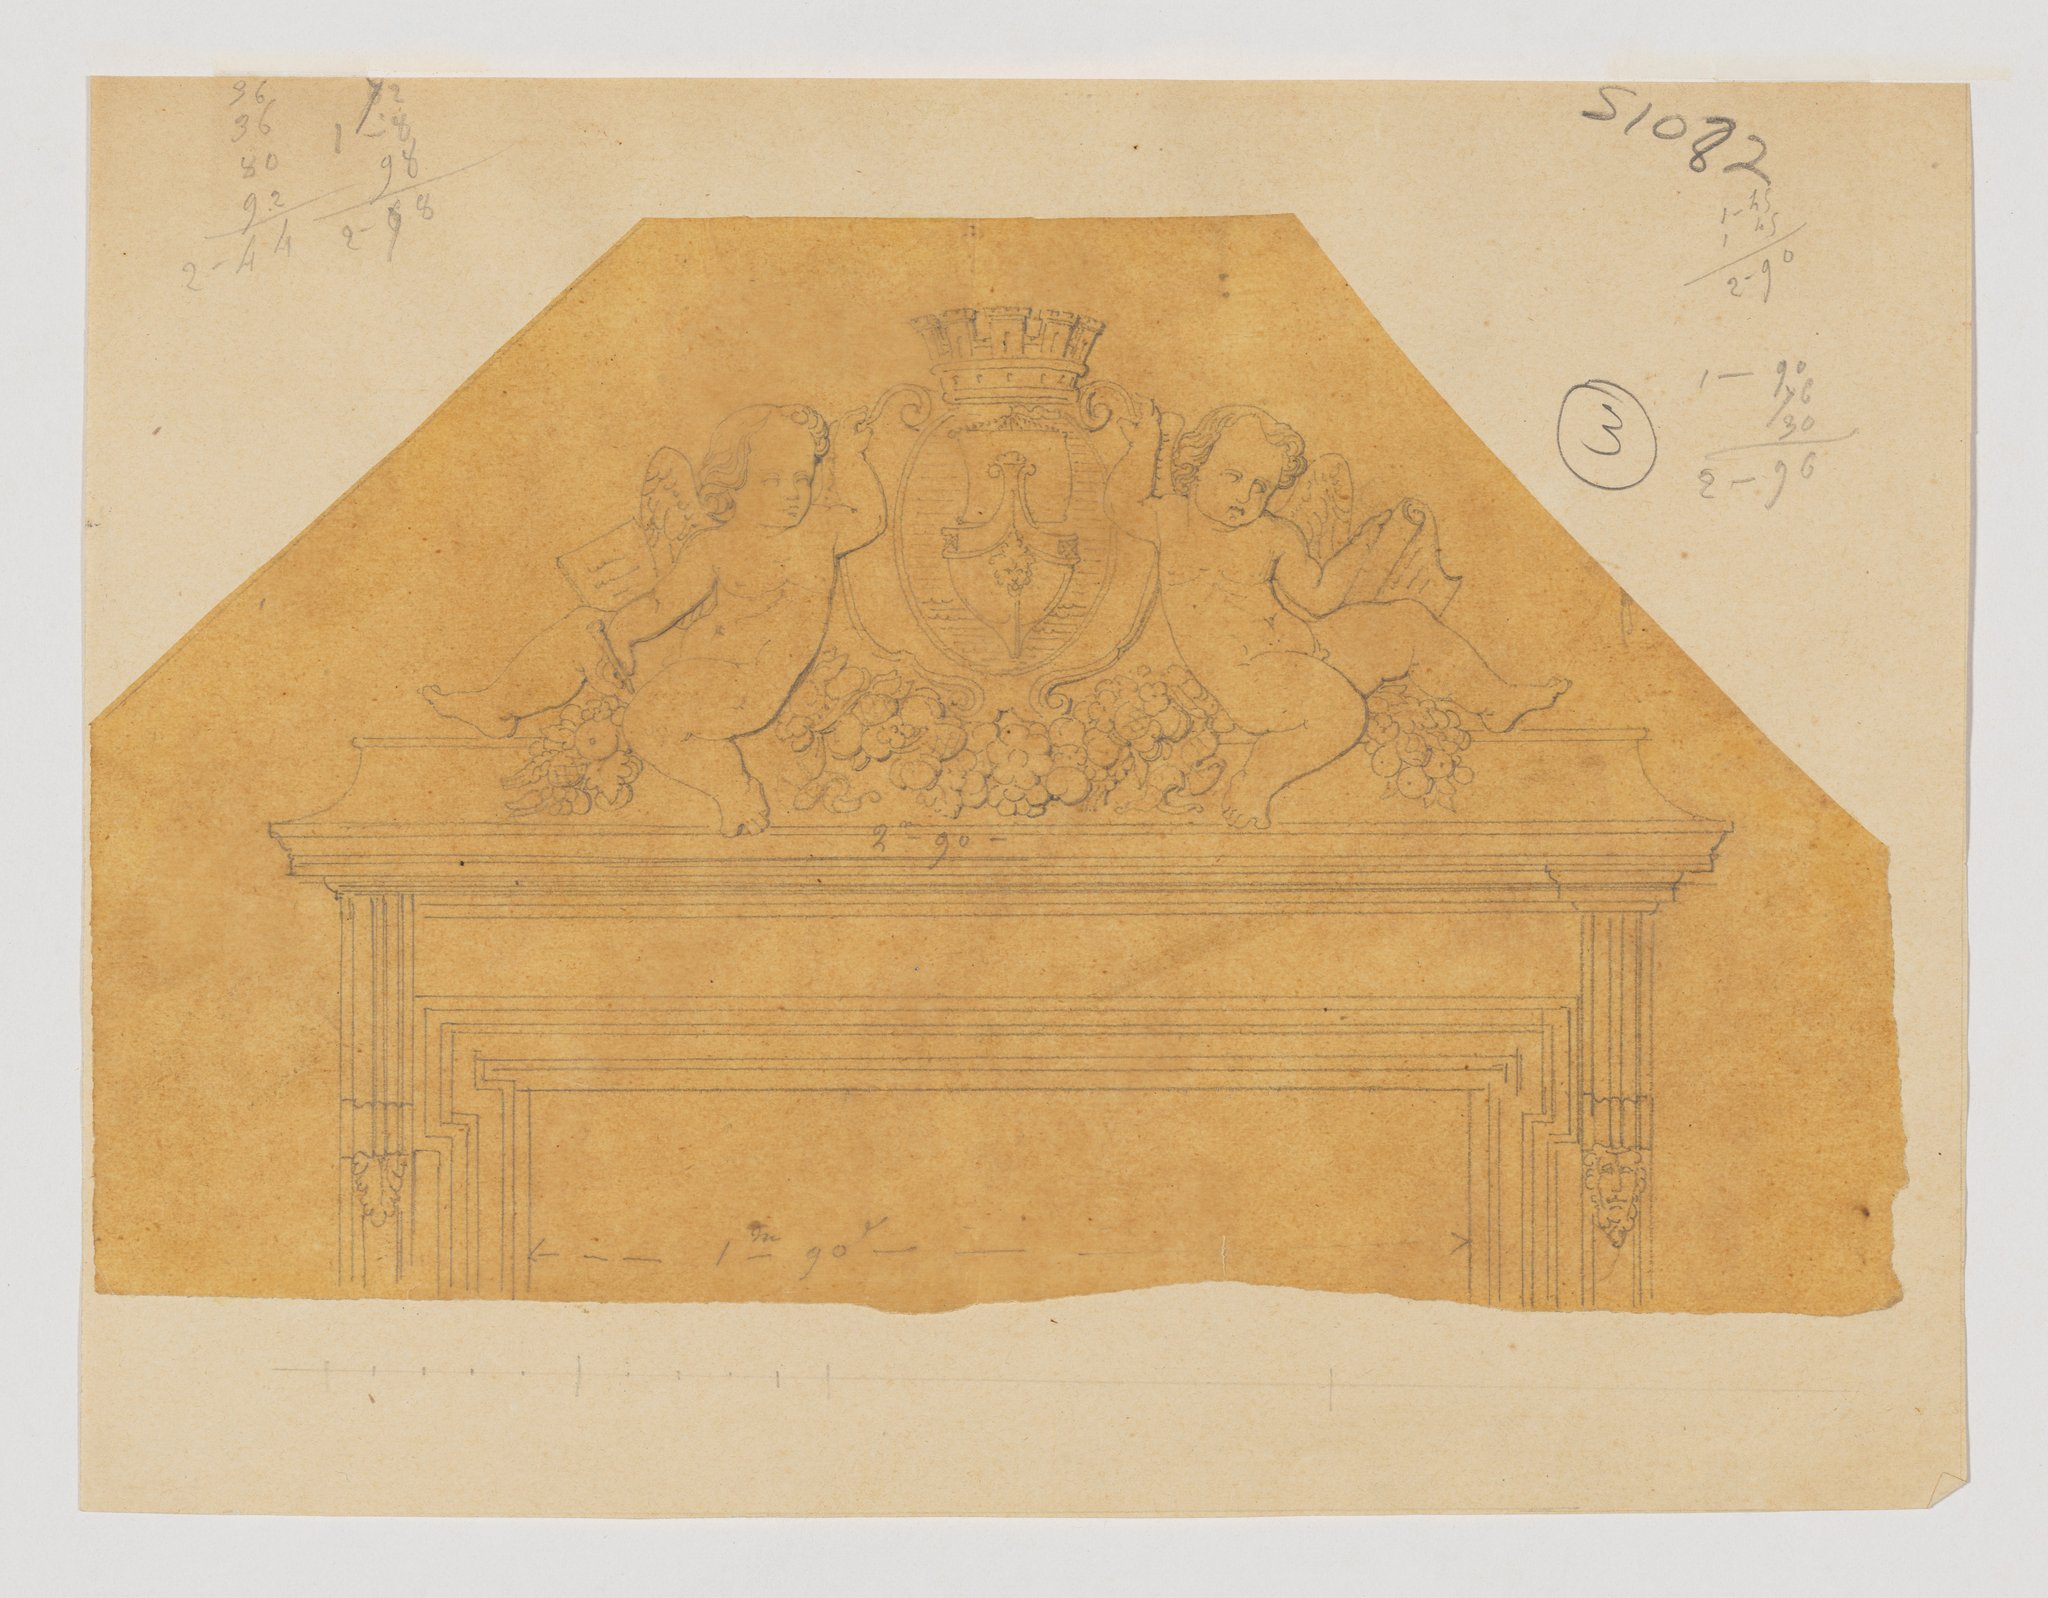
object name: drawing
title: Design for an Overdoor with Two outward facing Putti flanking a Coat of Arms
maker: jean-baptiste louis plantar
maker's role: artist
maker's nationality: french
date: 1834-1866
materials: graphite, ink, watercolor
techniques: pen